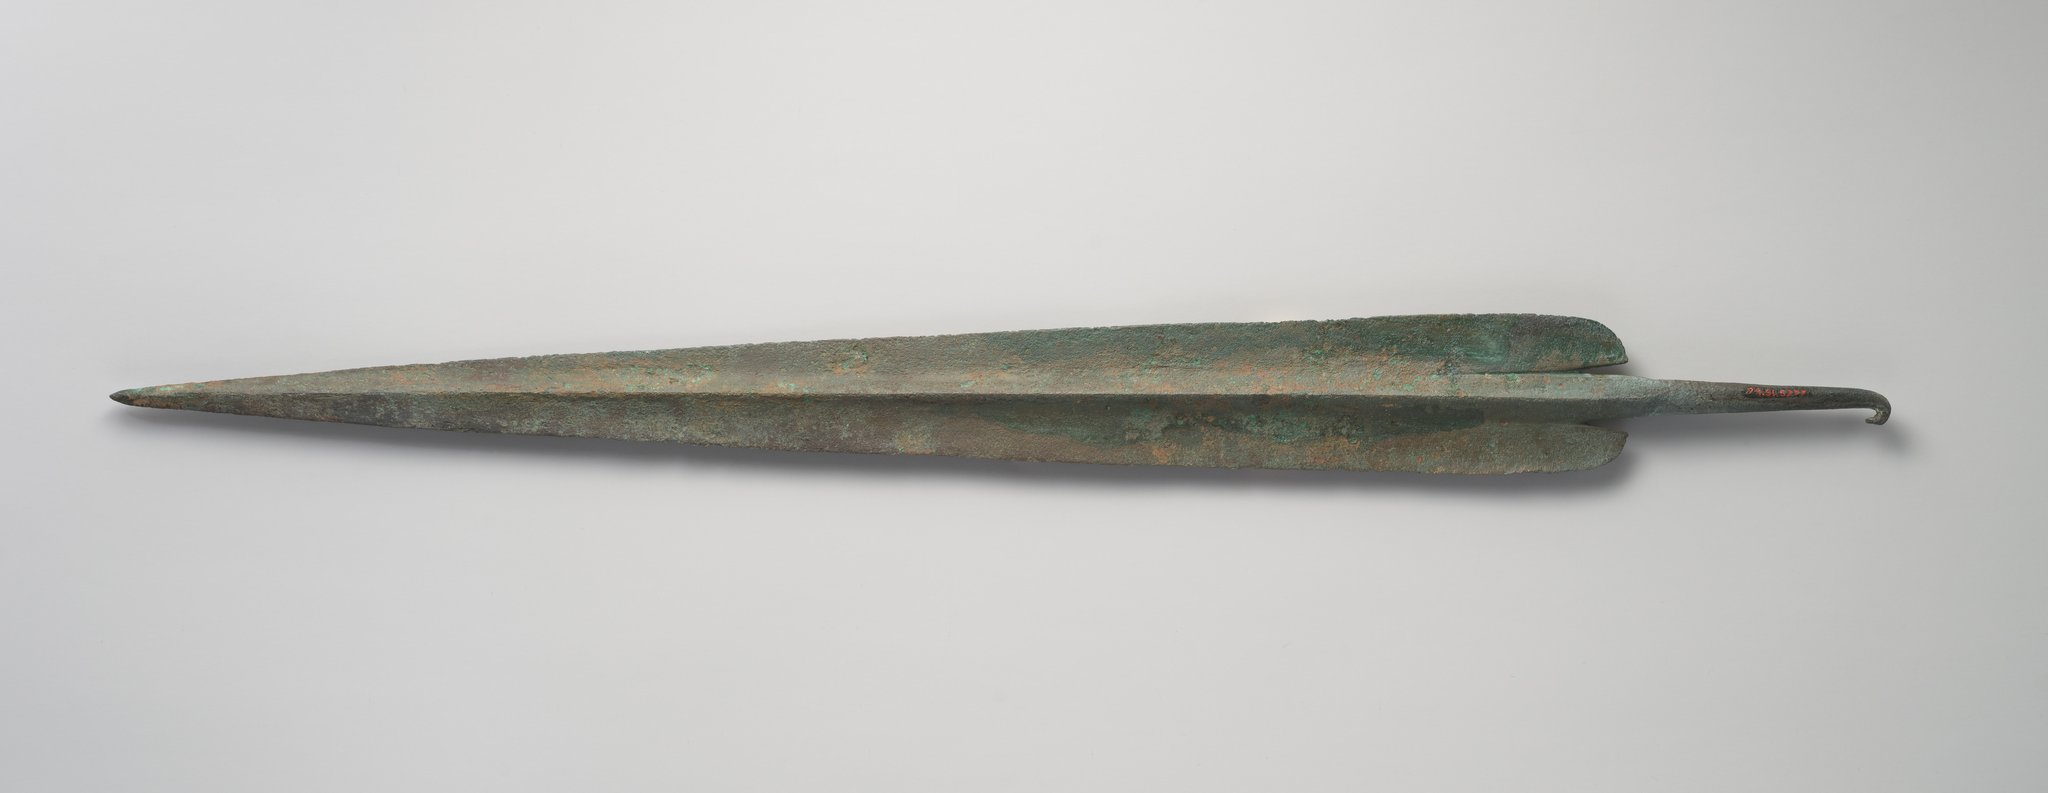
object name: spearhead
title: Bronze spearhead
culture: cypriot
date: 2000-1900 BCE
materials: bronze